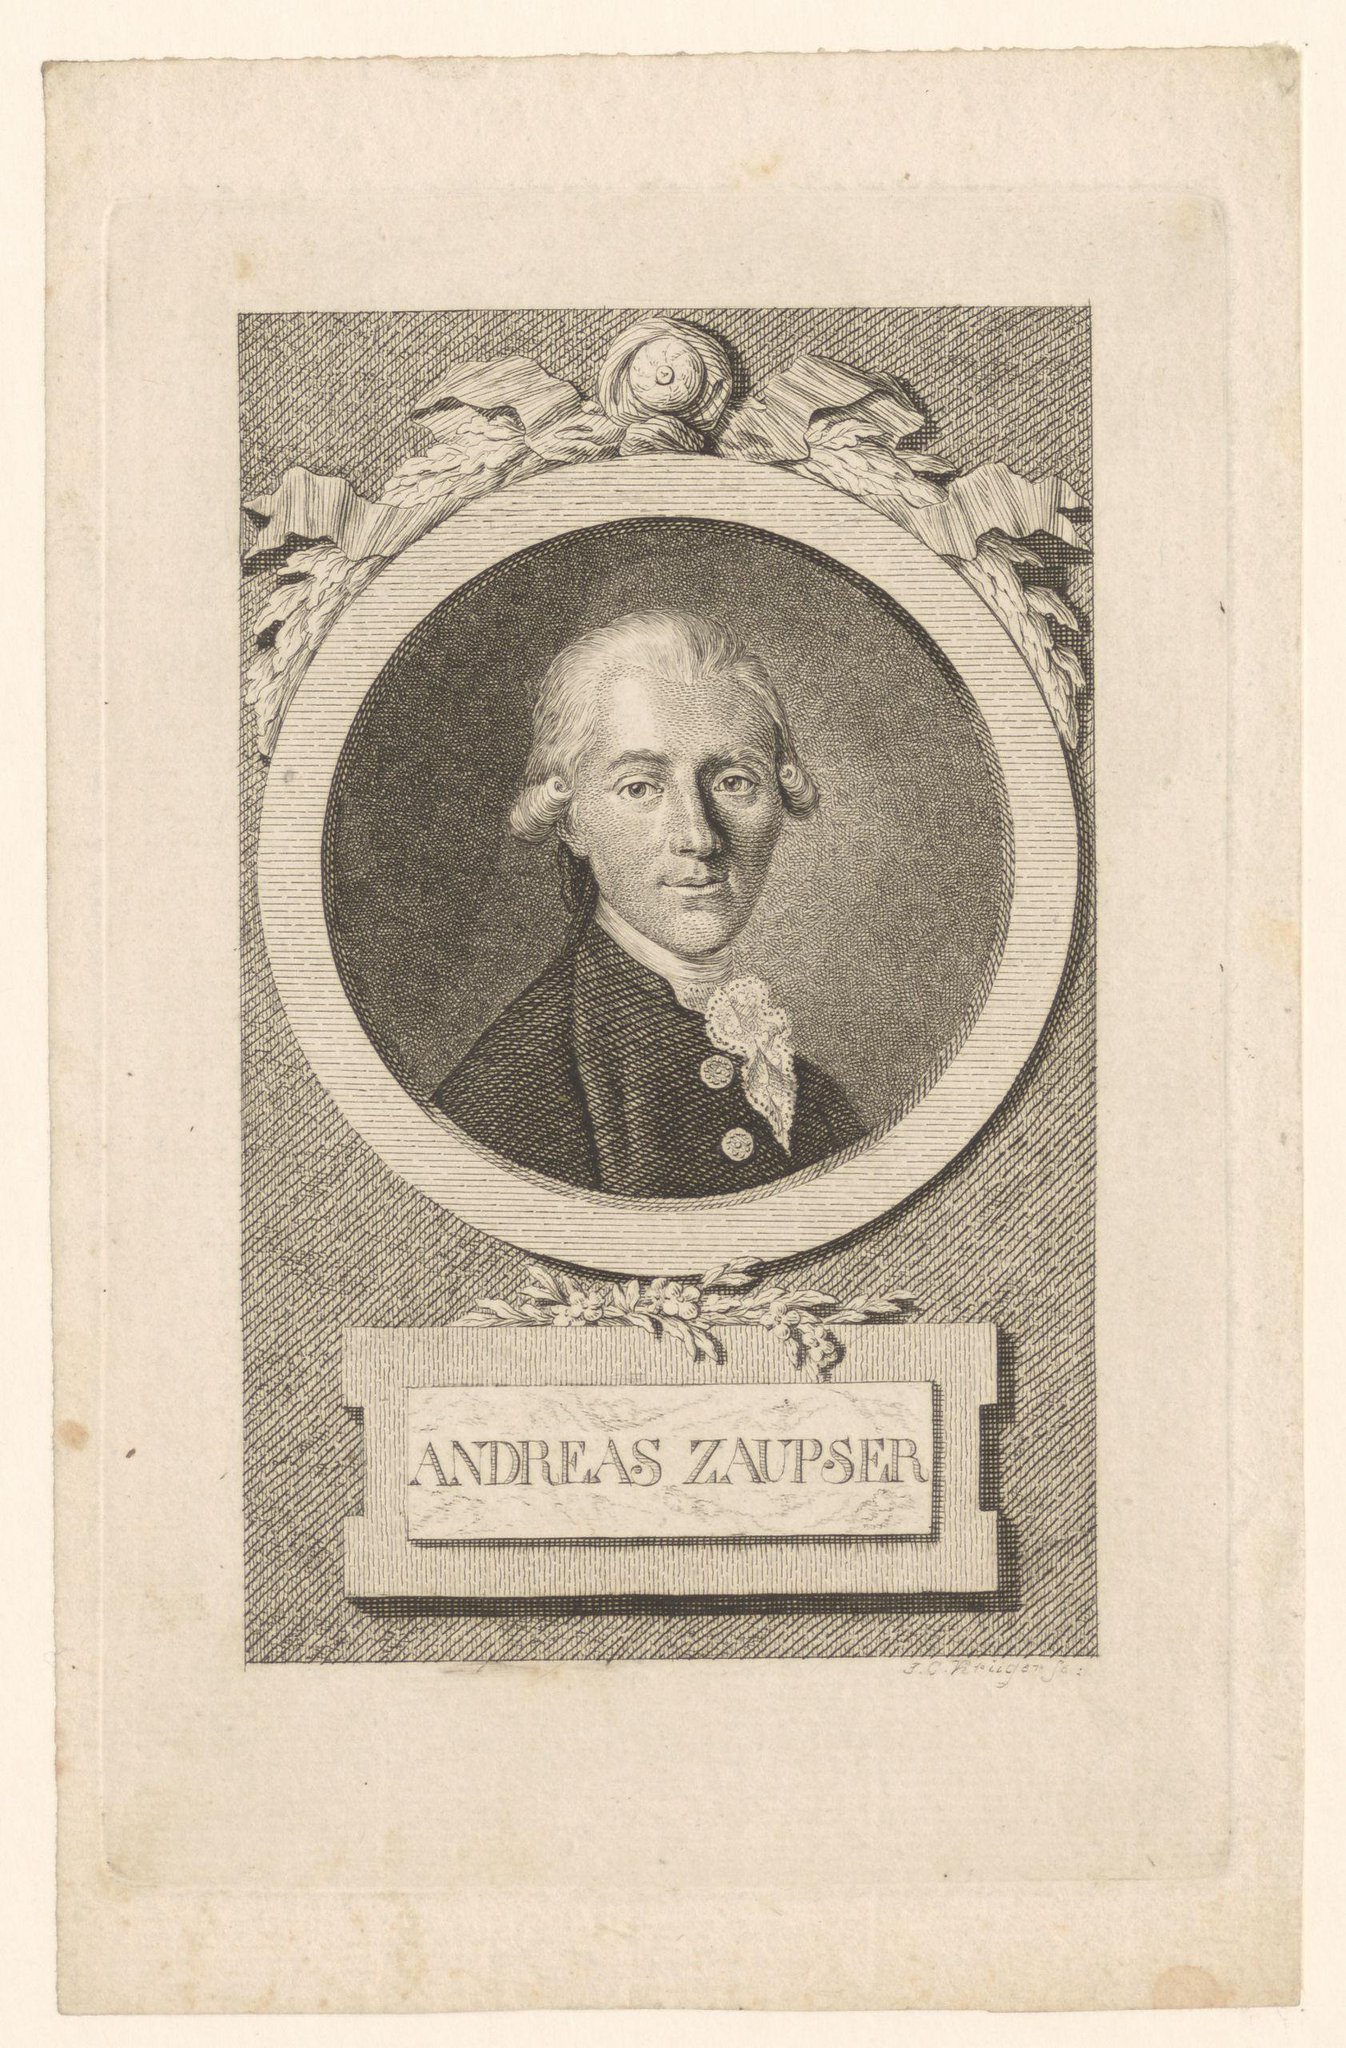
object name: print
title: Portret van Andreas Zaupser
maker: johann conrad krüger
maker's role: artist, painter, print maker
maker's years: 1733-1791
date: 1743-1785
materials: paper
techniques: engraving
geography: munich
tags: publisher, historical persons, writer, poet, author, scholar, philosopher (+ portrait of scholar, scientist)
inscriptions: collector's mark: Lugt 2228